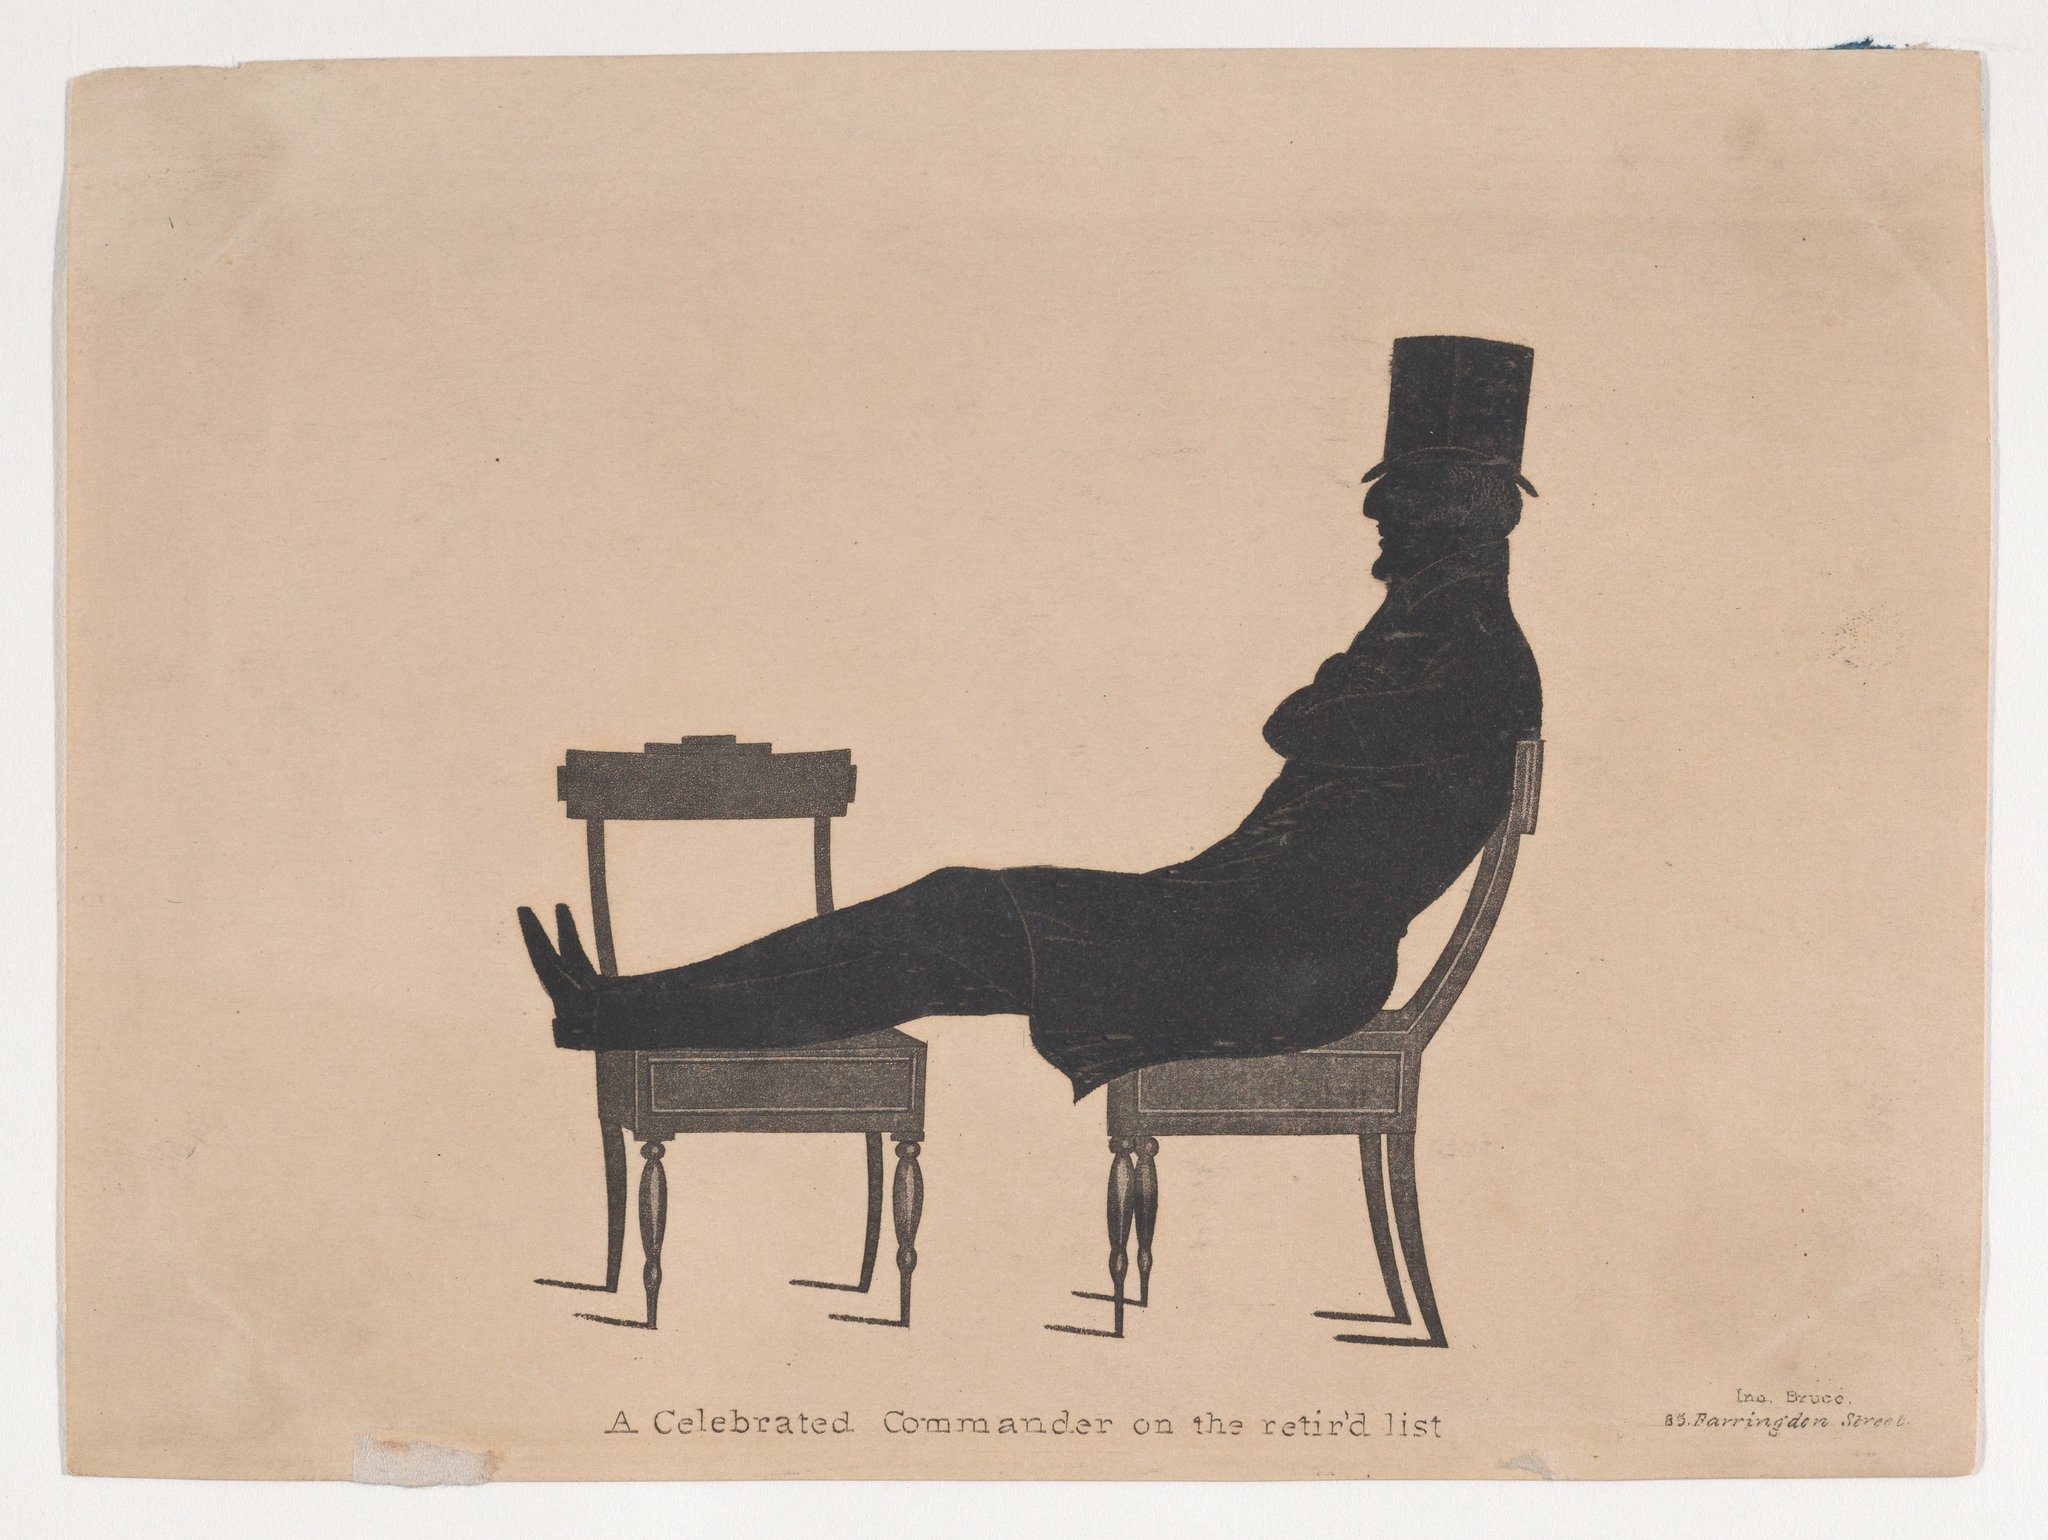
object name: print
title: Silhouette of a Celebrated Commander on the Retir'd List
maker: john bruce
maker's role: artist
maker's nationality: british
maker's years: 1825-1835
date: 1830-1835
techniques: aquatint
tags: men